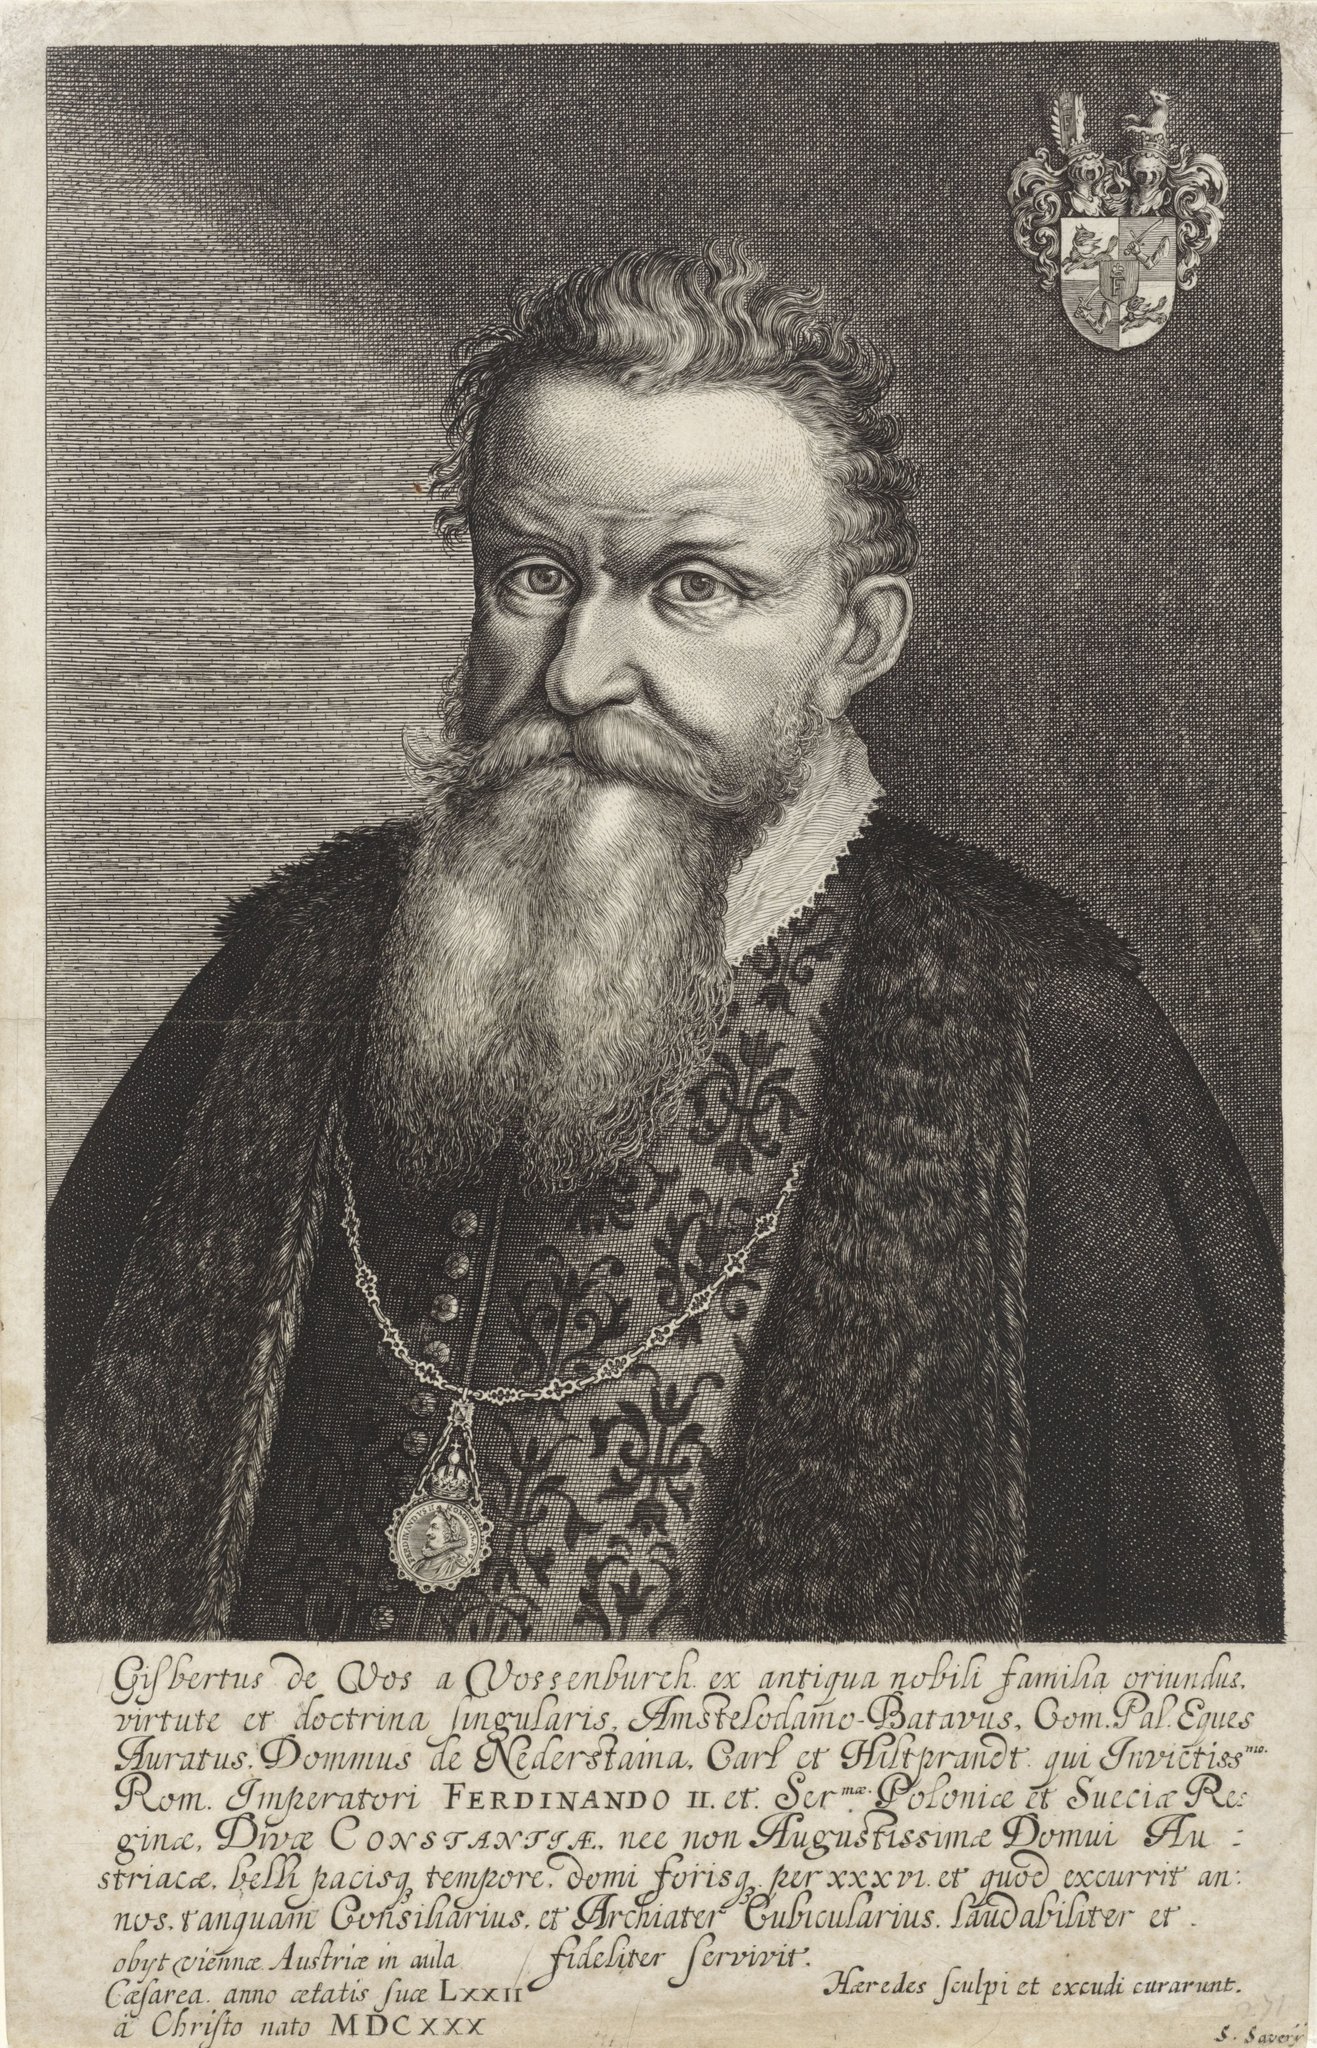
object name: print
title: Portret van Gijsbertus de Vos van Vossenburch, medicus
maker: salomon savery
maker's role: print maker, publisher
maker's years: 1594-1683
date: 1630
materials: paper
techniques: engraving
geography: amsterdam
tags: armorial bearing, heraldry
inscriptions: collector's mark: Lugt 2478, collector's mark: Lugt 2228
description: Het portret is in opdracht van de erven van Gijsbertus de Vos van Vossenburch gegraveerd en tevens in hun beheer uitgegeven, zie opschrift.